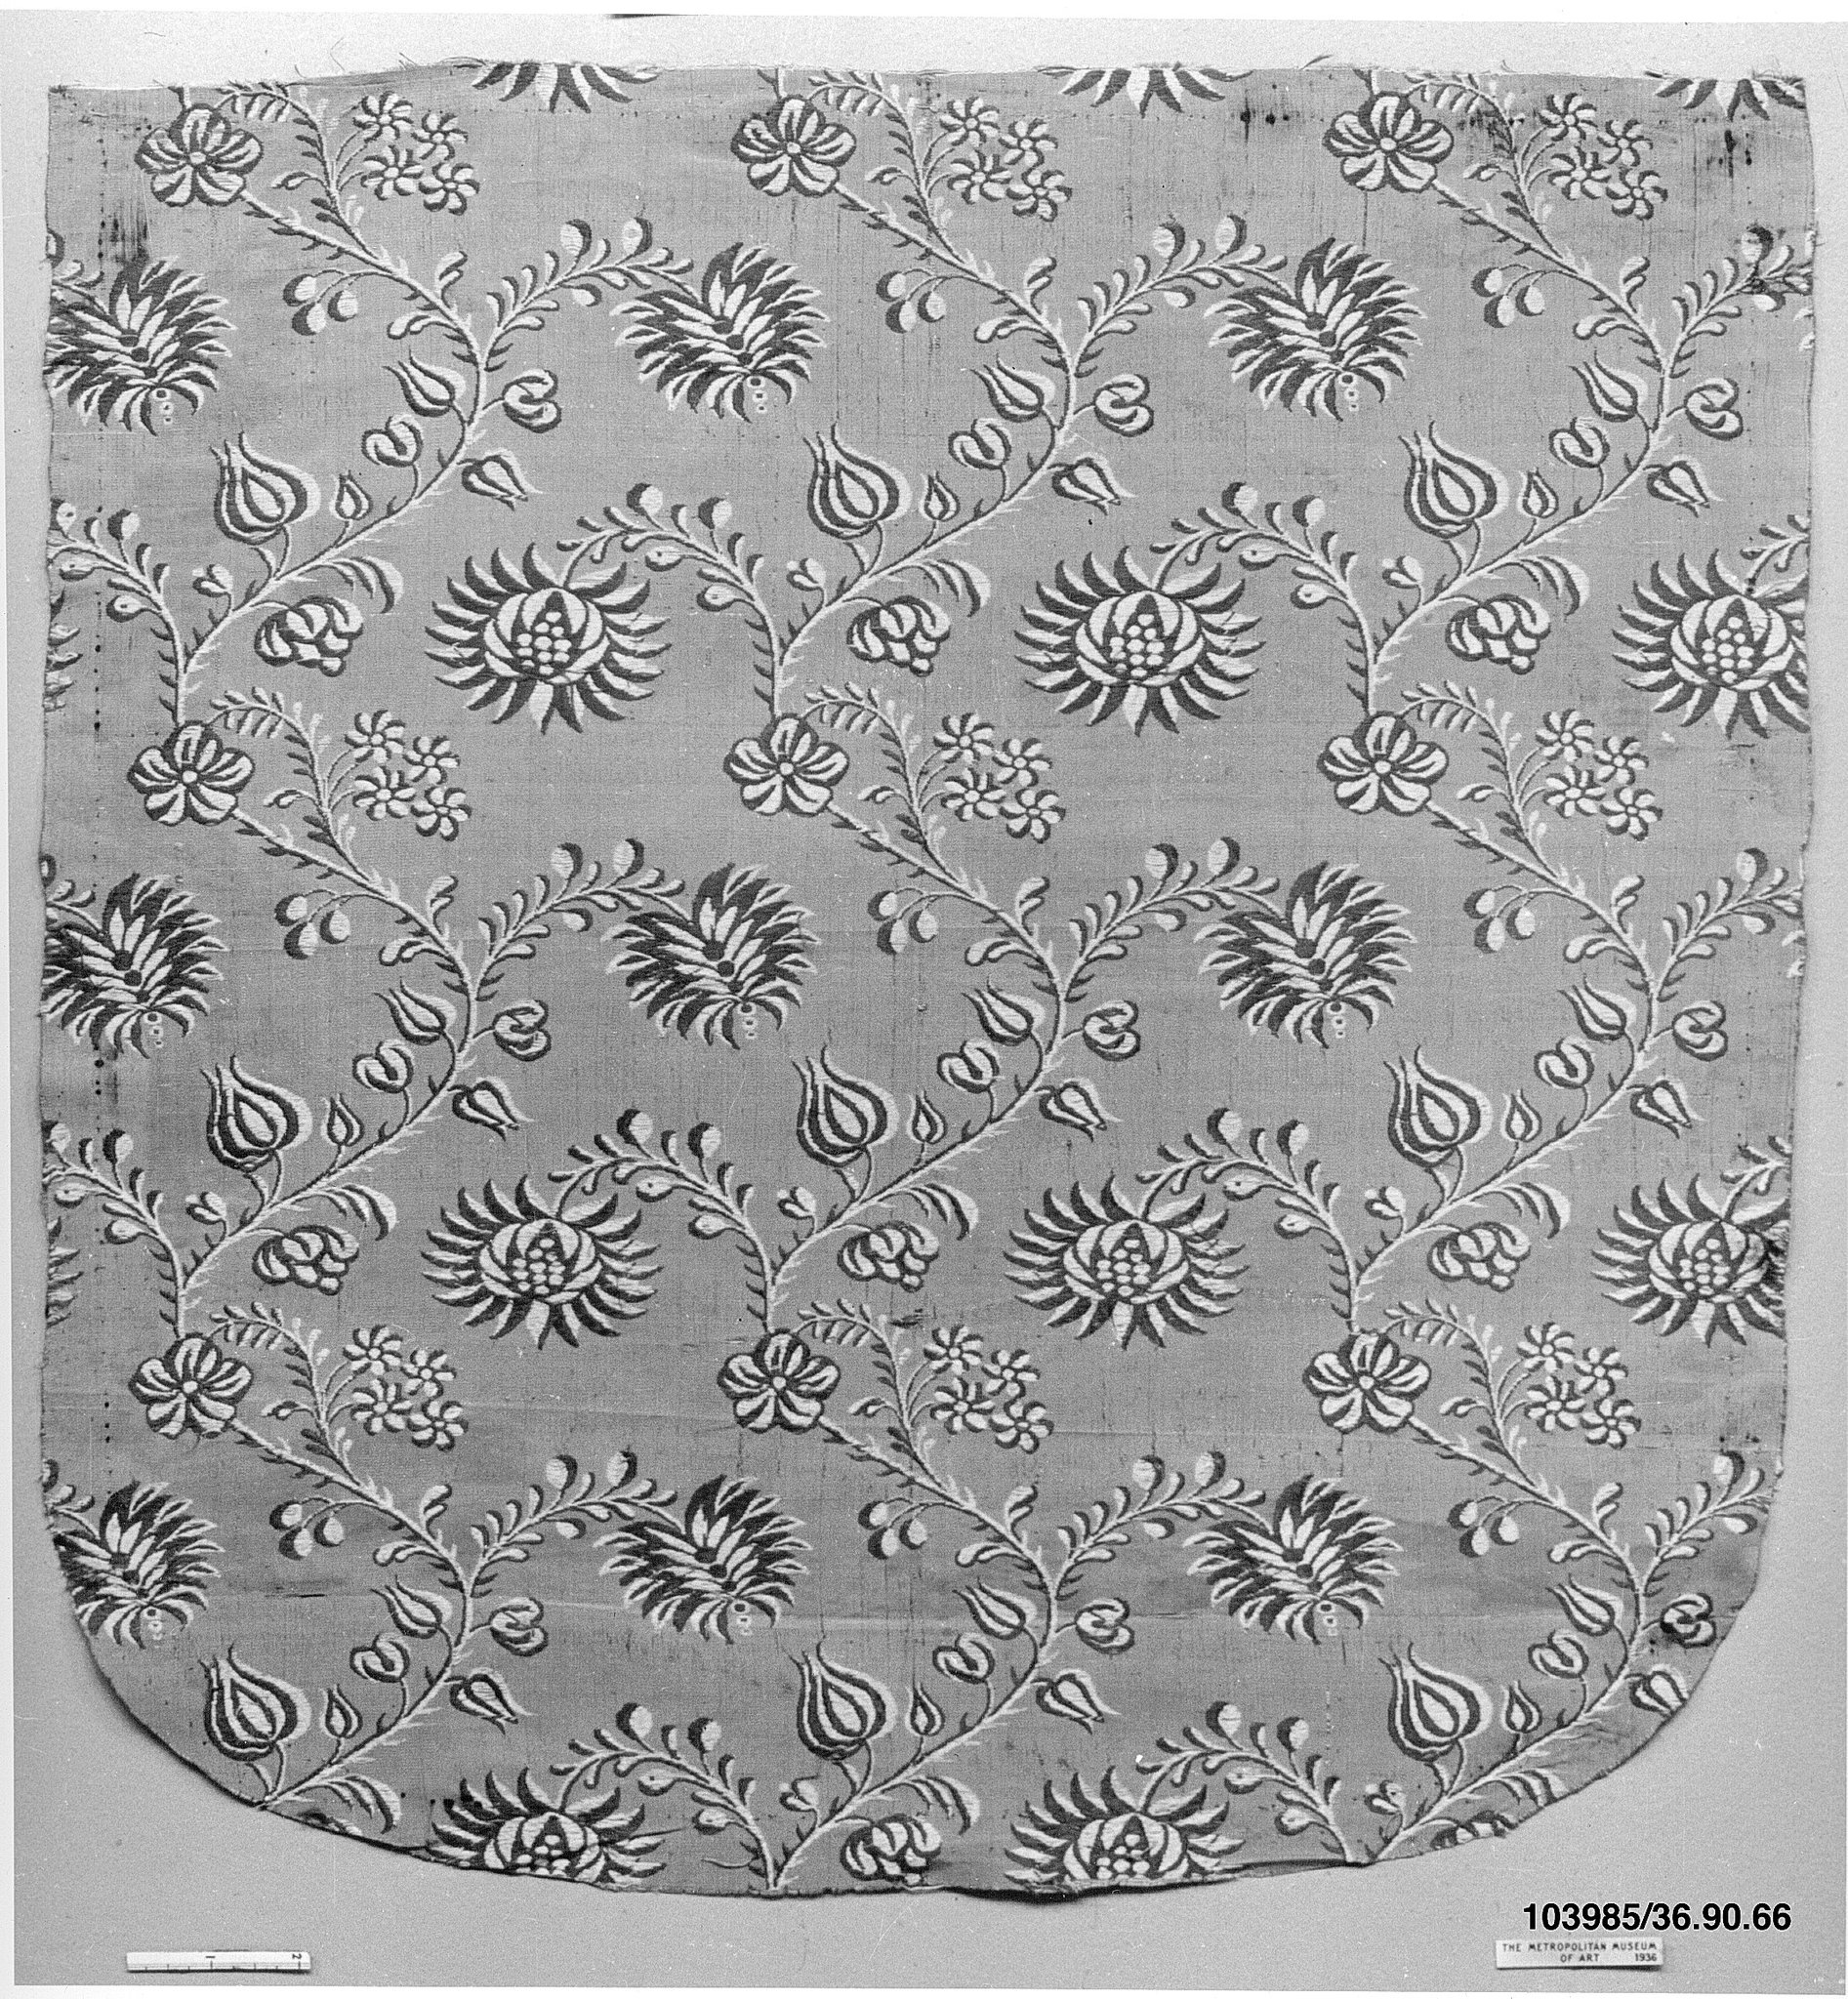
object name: piece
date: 1750-1760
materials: silk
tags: flowers,leaves